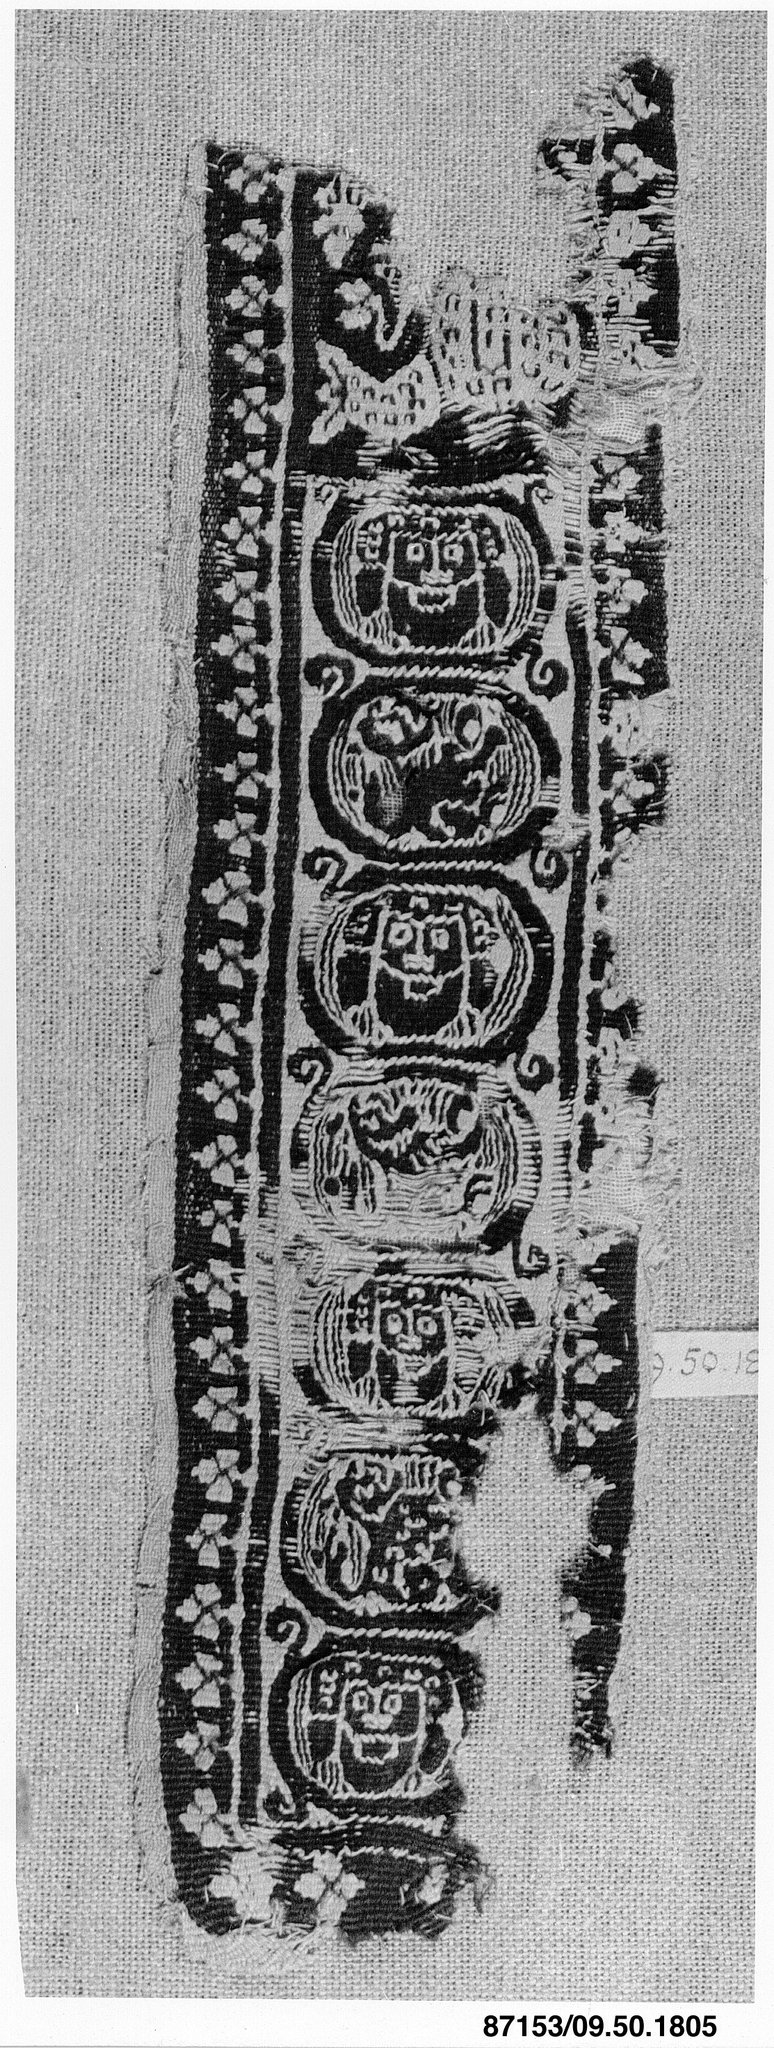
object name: shoulder band fragment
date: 301-500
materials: linen, wool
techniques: weave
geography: egypt